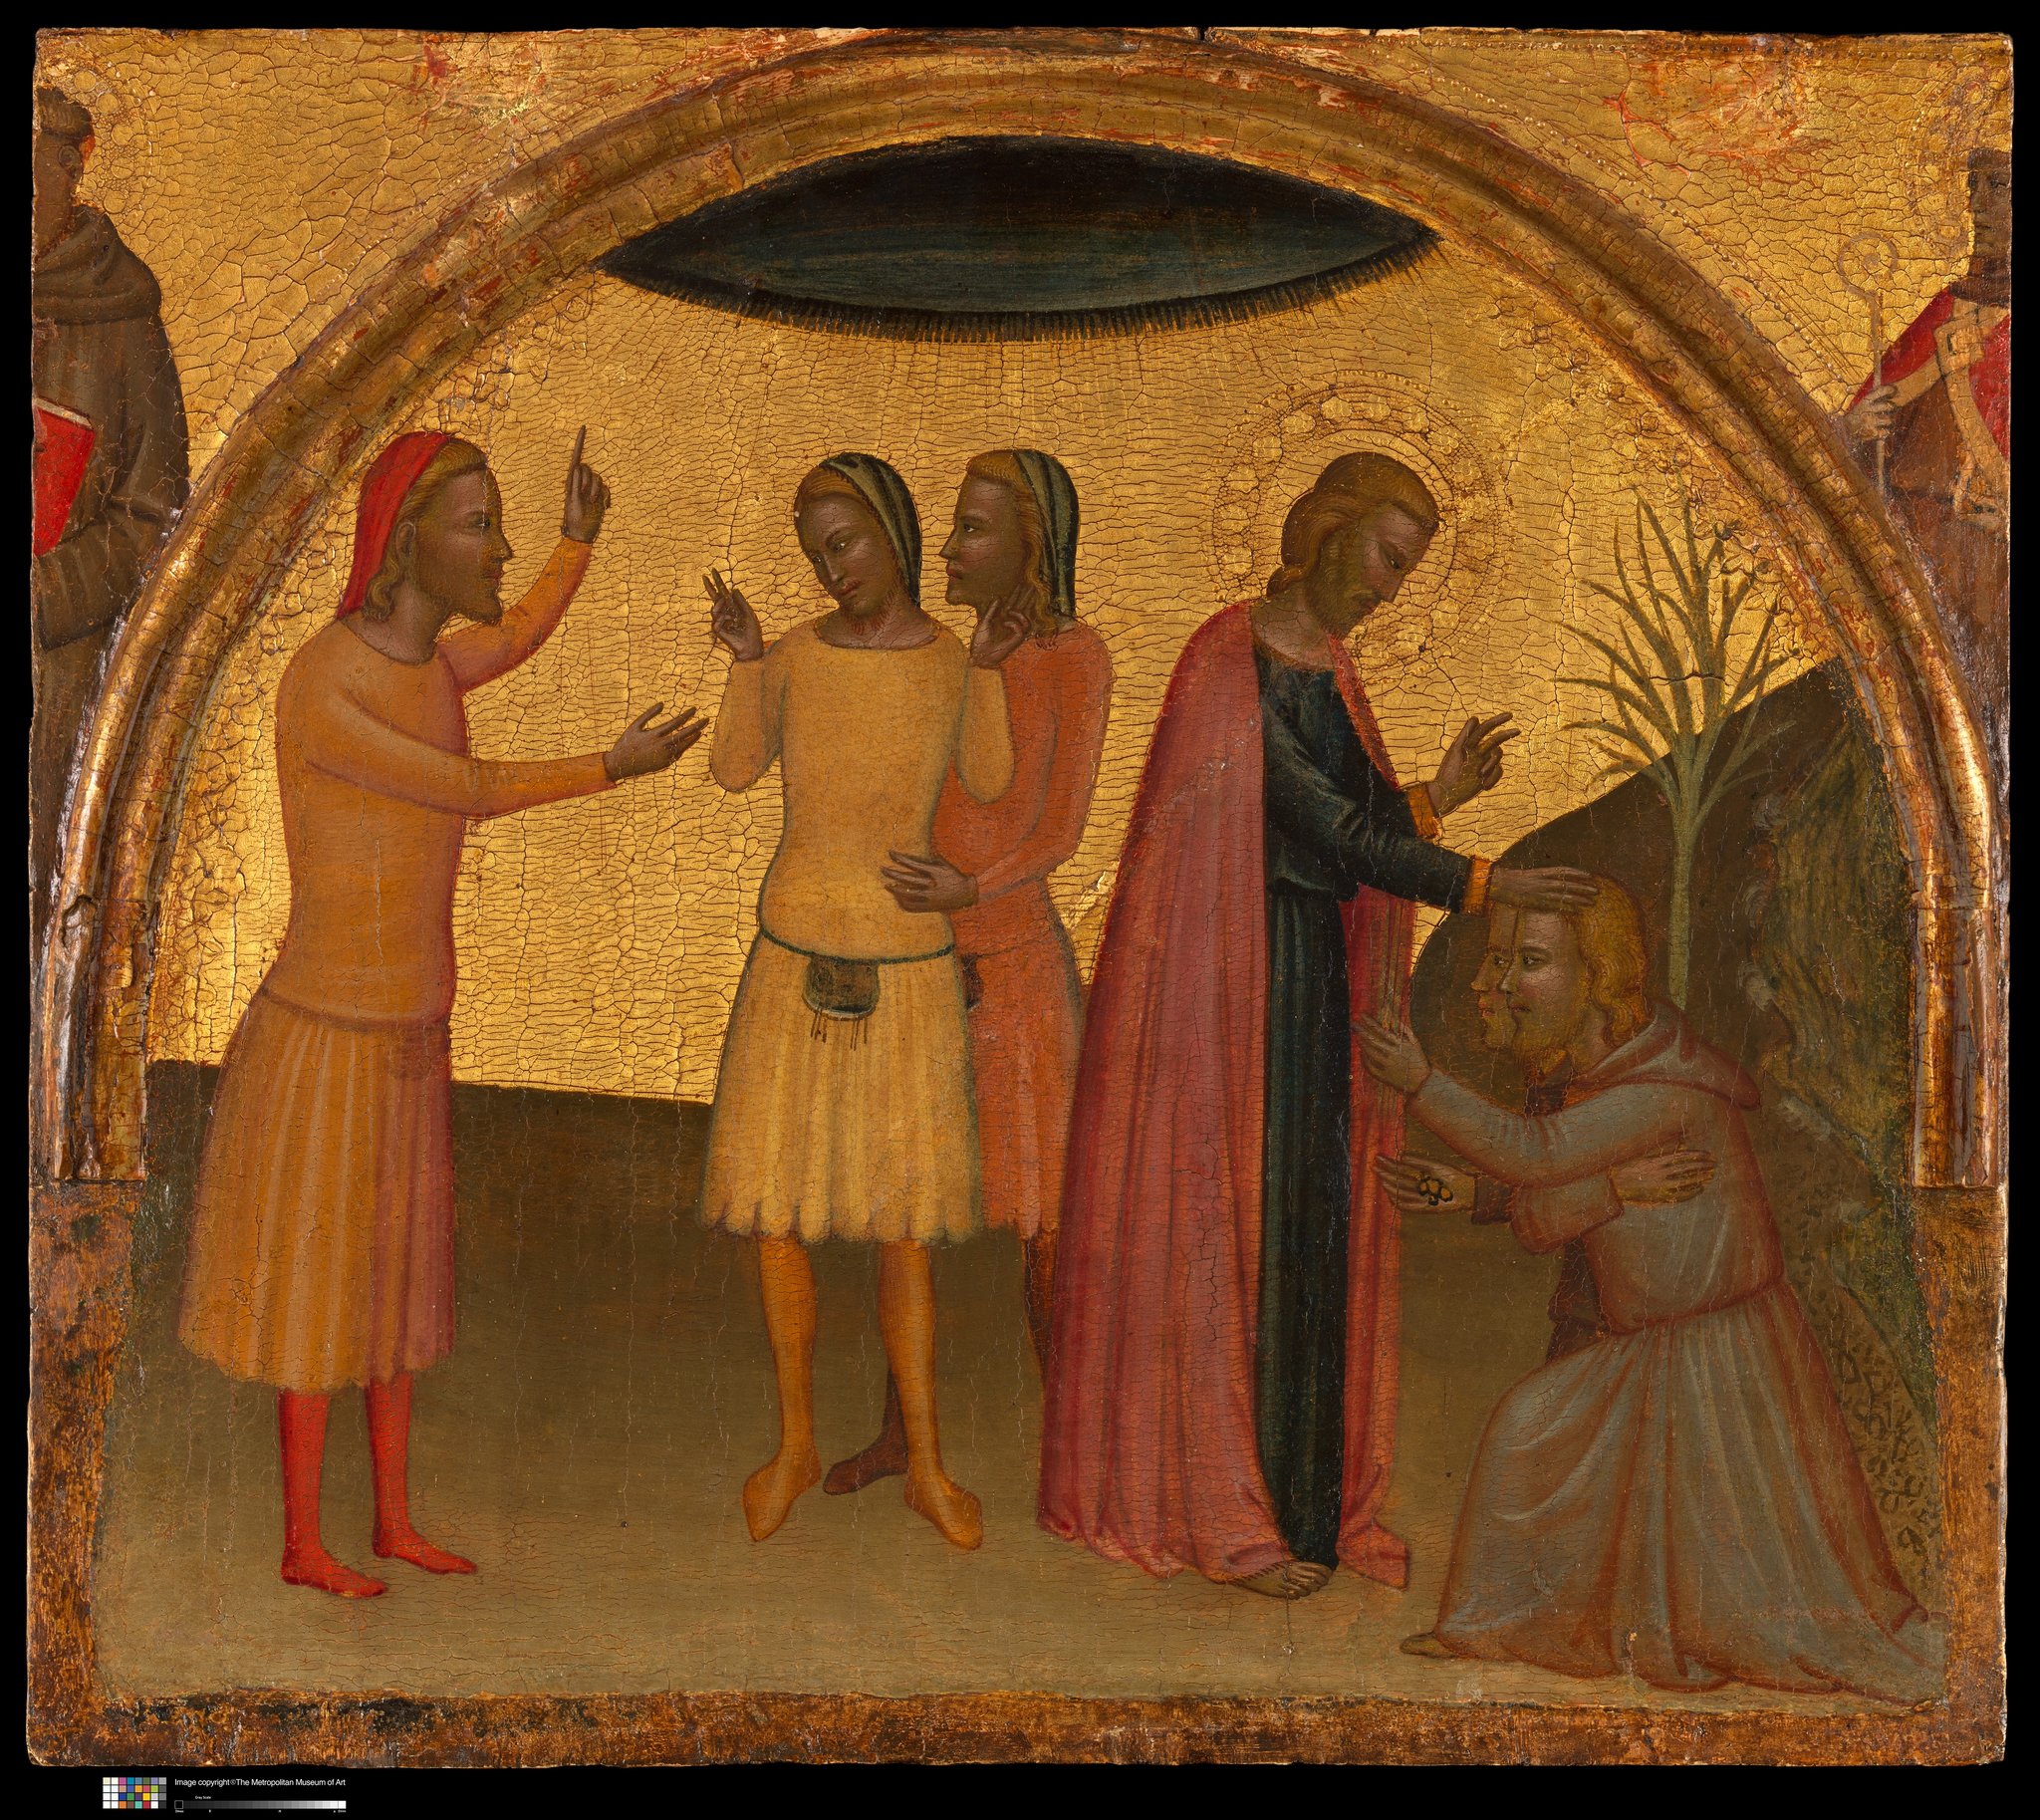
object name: painting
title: Saint John the Evangelist with Acteus and Eugenius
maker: francescuccio ghissi (francesco di cecco ghissi)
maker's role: artist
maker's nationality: italian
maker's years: 1359-1374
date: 1370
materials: gold leaf, paint, wood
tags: men,women,saint john the evangelist